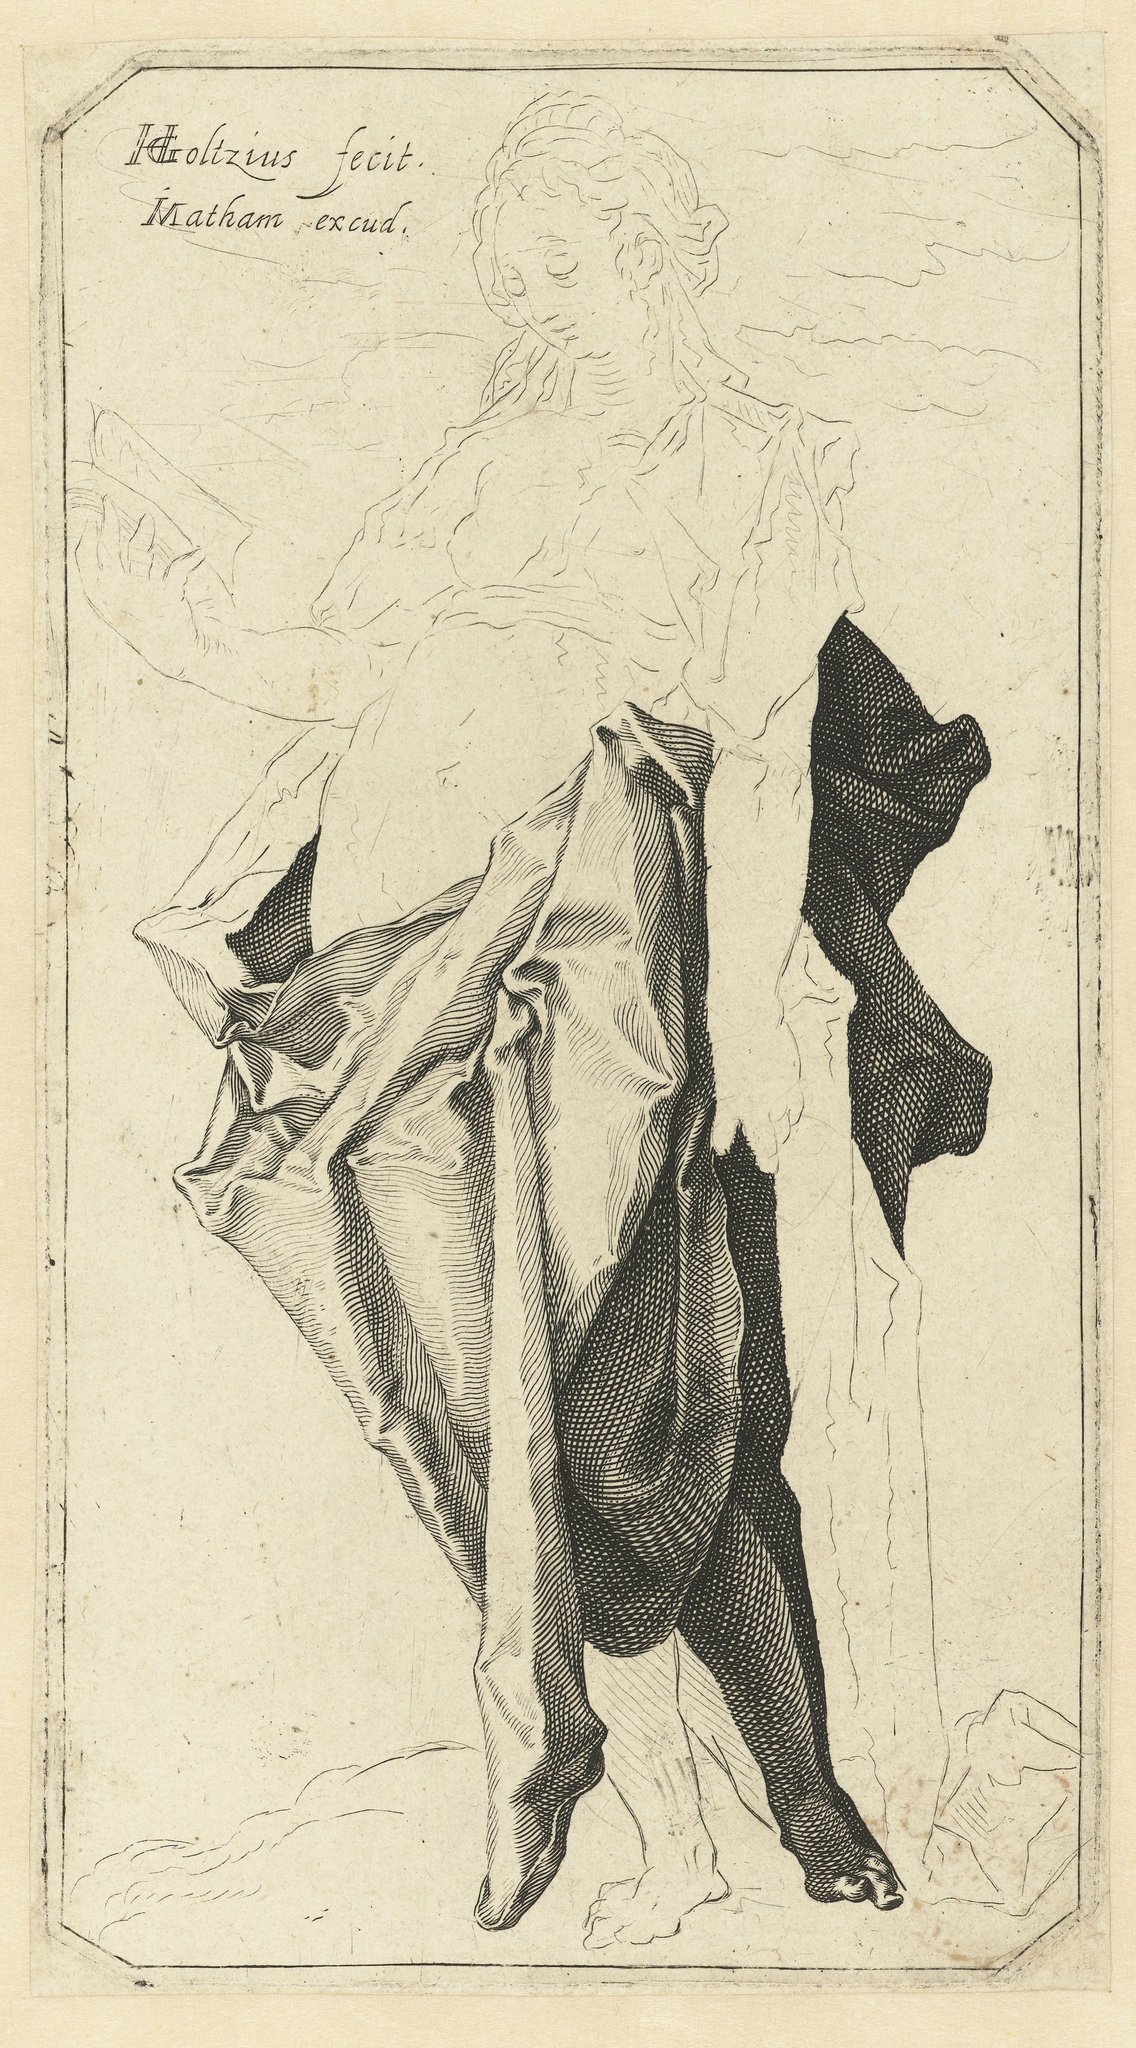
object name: print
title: Maria Magdalena (?)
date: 1580-1586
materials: paper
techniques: engraving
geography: haarlem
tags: the penitent harlot mary magdalene; possible attributes: book (or scroll), crown, crown of thorns, crucifix, jar of ointment, mirror, musical instrument, palm-branch, rosary, scourge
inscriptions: signature: ‘HGoltzius fecit’, collector's mark: Lugt 240, address: ‘Matham excud.’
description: Staande vrouwenfiguur, ten voeten uit, waarschijnlijk Maria Magdalena. Druk van een onvoltooide plaat.